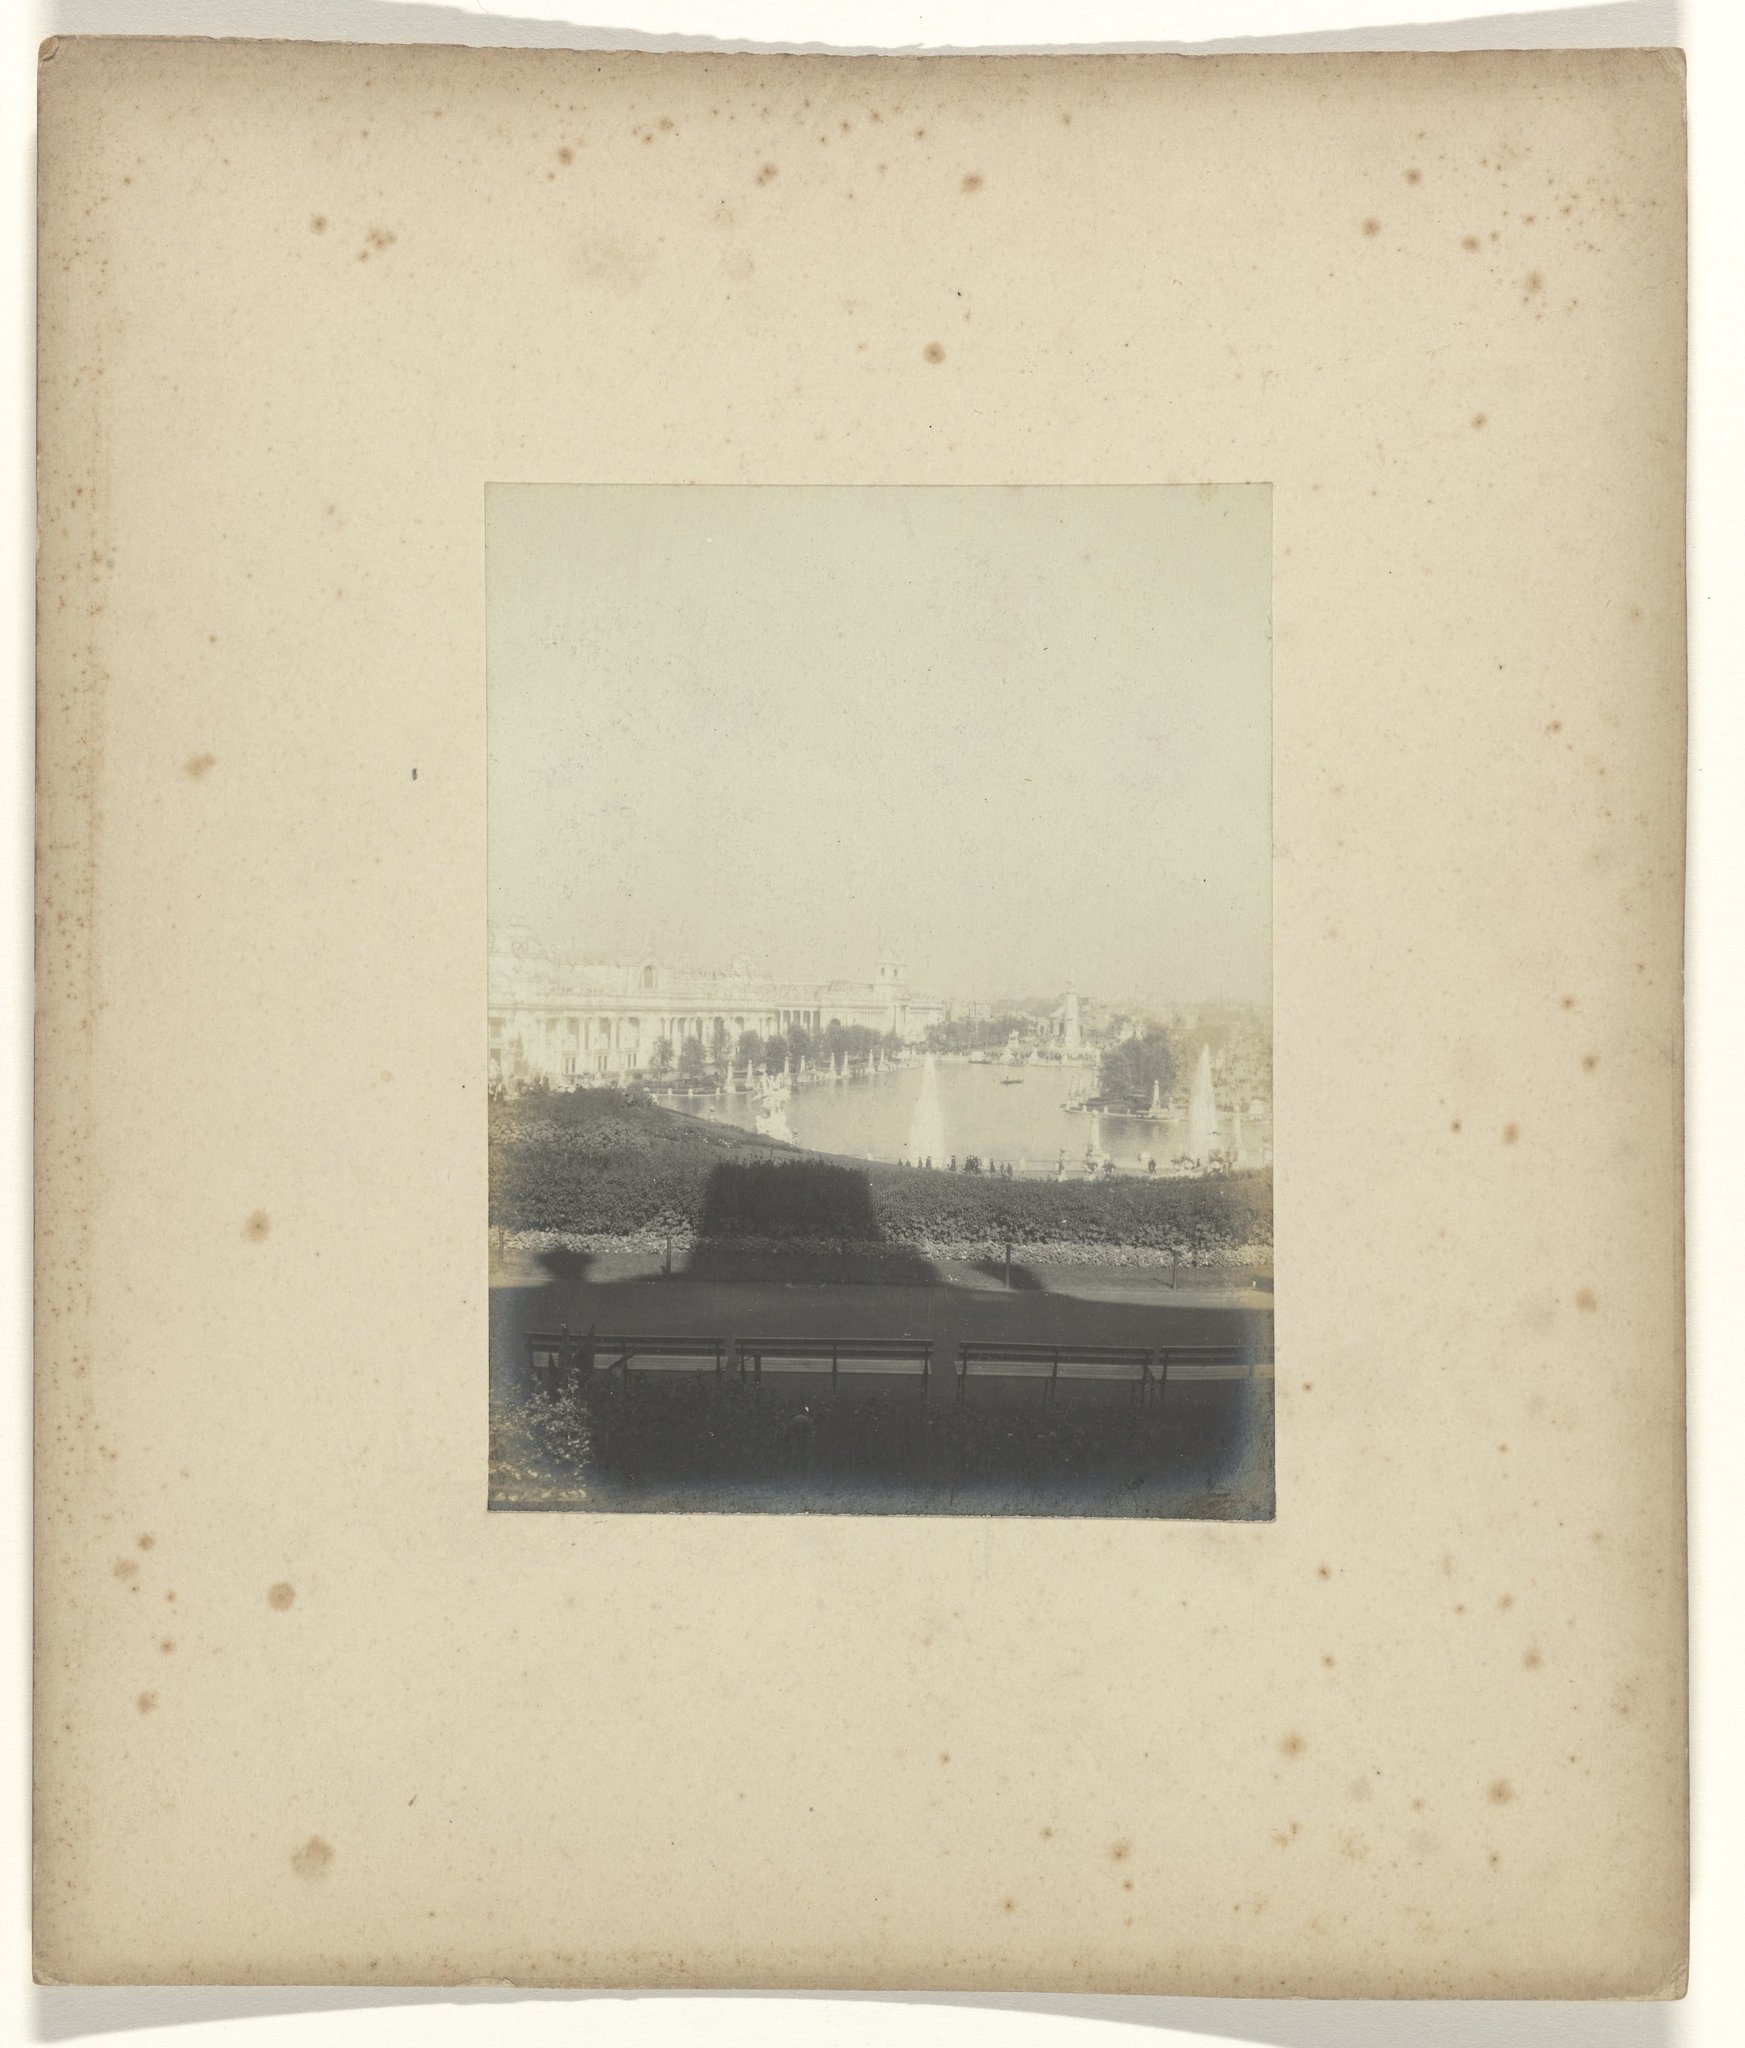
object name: photograph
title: Gezicht op het Grand Basin (of: Lagoon) op het terrein van de wereldtentoonstelling in St. Louis (Louisiana Purchase Exposition), 1904, met links Electricity Palace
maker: jan schüller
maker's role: draughtsman, painter, print maker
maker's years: 1871-1915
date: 1904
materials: cardboard, paper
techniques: gelatin silver print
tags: world fair, world exhibition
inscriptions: annotation: ‘’t midden van ’t enorme // Tentoonstellings-terrein’, annotation: ‘Gezicht op de Lagoon’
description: Gezicht op het Grand Basin (of: Lagoon) op het terrein van de wereldtentoonstelling in St. Louis (Louisiana Purchase Exposition), 1904, met links Electricity Palace.